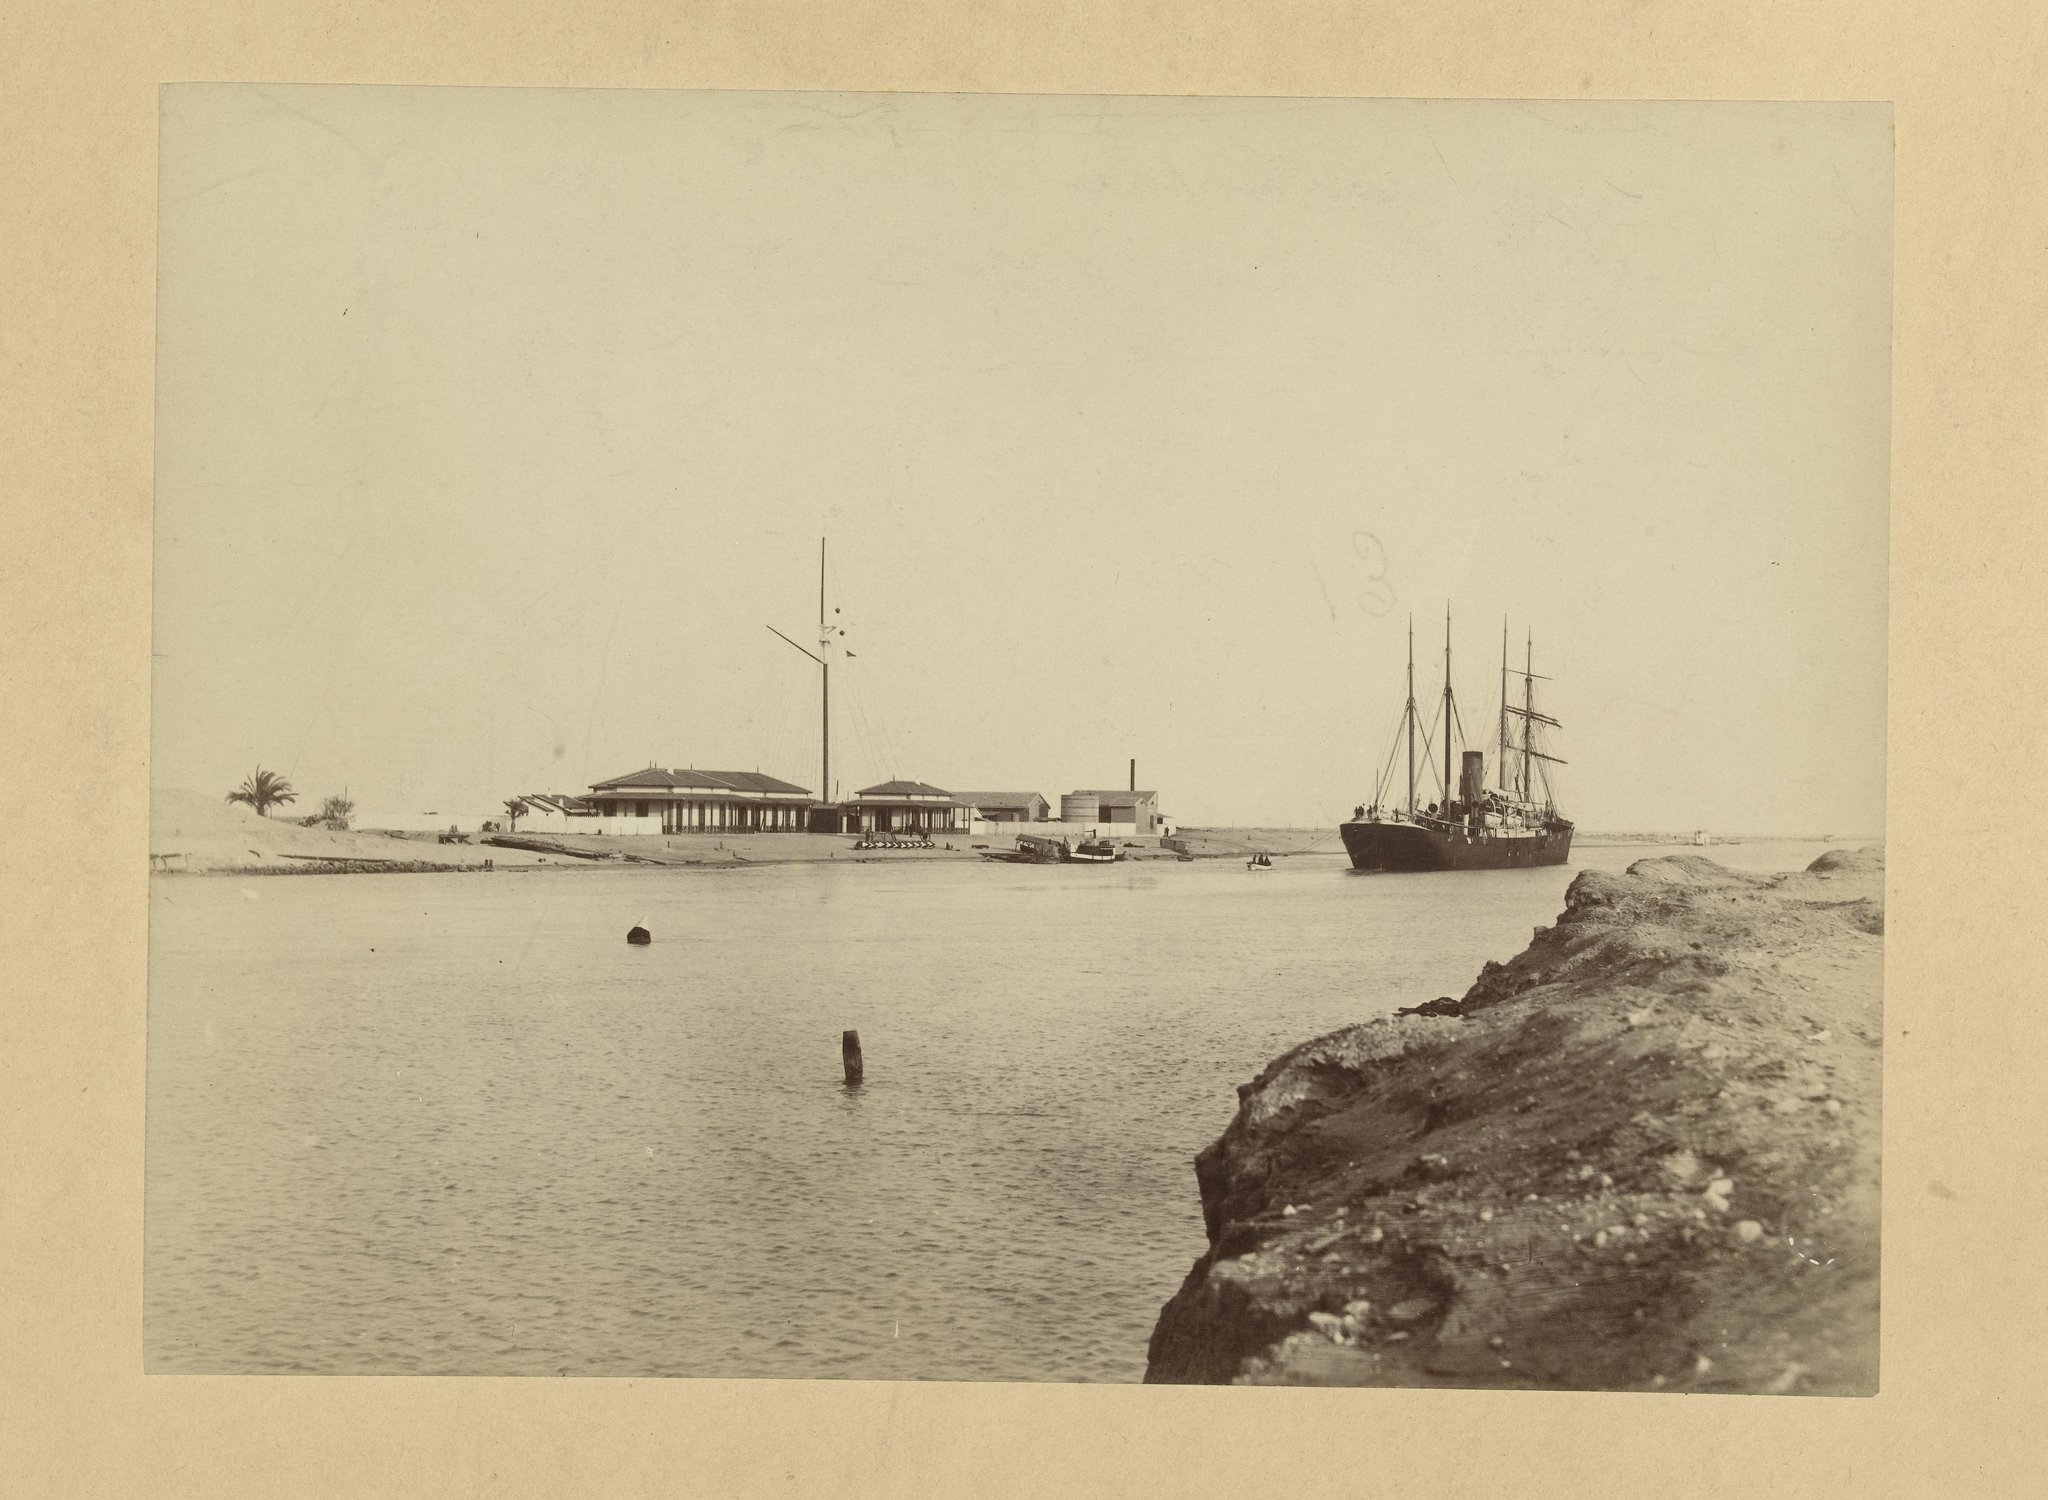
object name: photograph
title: Seinstation bij het Suezkanaal, Egypte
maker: Anonymous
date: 1890-1895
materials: cardboard, paper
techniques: albumen print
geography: egypt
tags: visual signalling, canal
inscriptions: check stamp: ‘Bristol/ L.M.’, stamp: ‘Gemeentelijke bibliotheek/ Rotterdam’, title: ‘E 1. Seinstation. Suez kanaal.’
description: Onderdeel van een groep door fotograaf Richard Polak op reis verzamelde foto’s. Deze foto is samen met andere op zijn reizen verzamelde foto's tentoongesteld bij de Rotterdamsche Kunstkring (1895), Arti en Amicitiae te Amsterdam (1897-1898?) en Societeit 't Collegie te Kampen (datum vooralsnog onbekend).